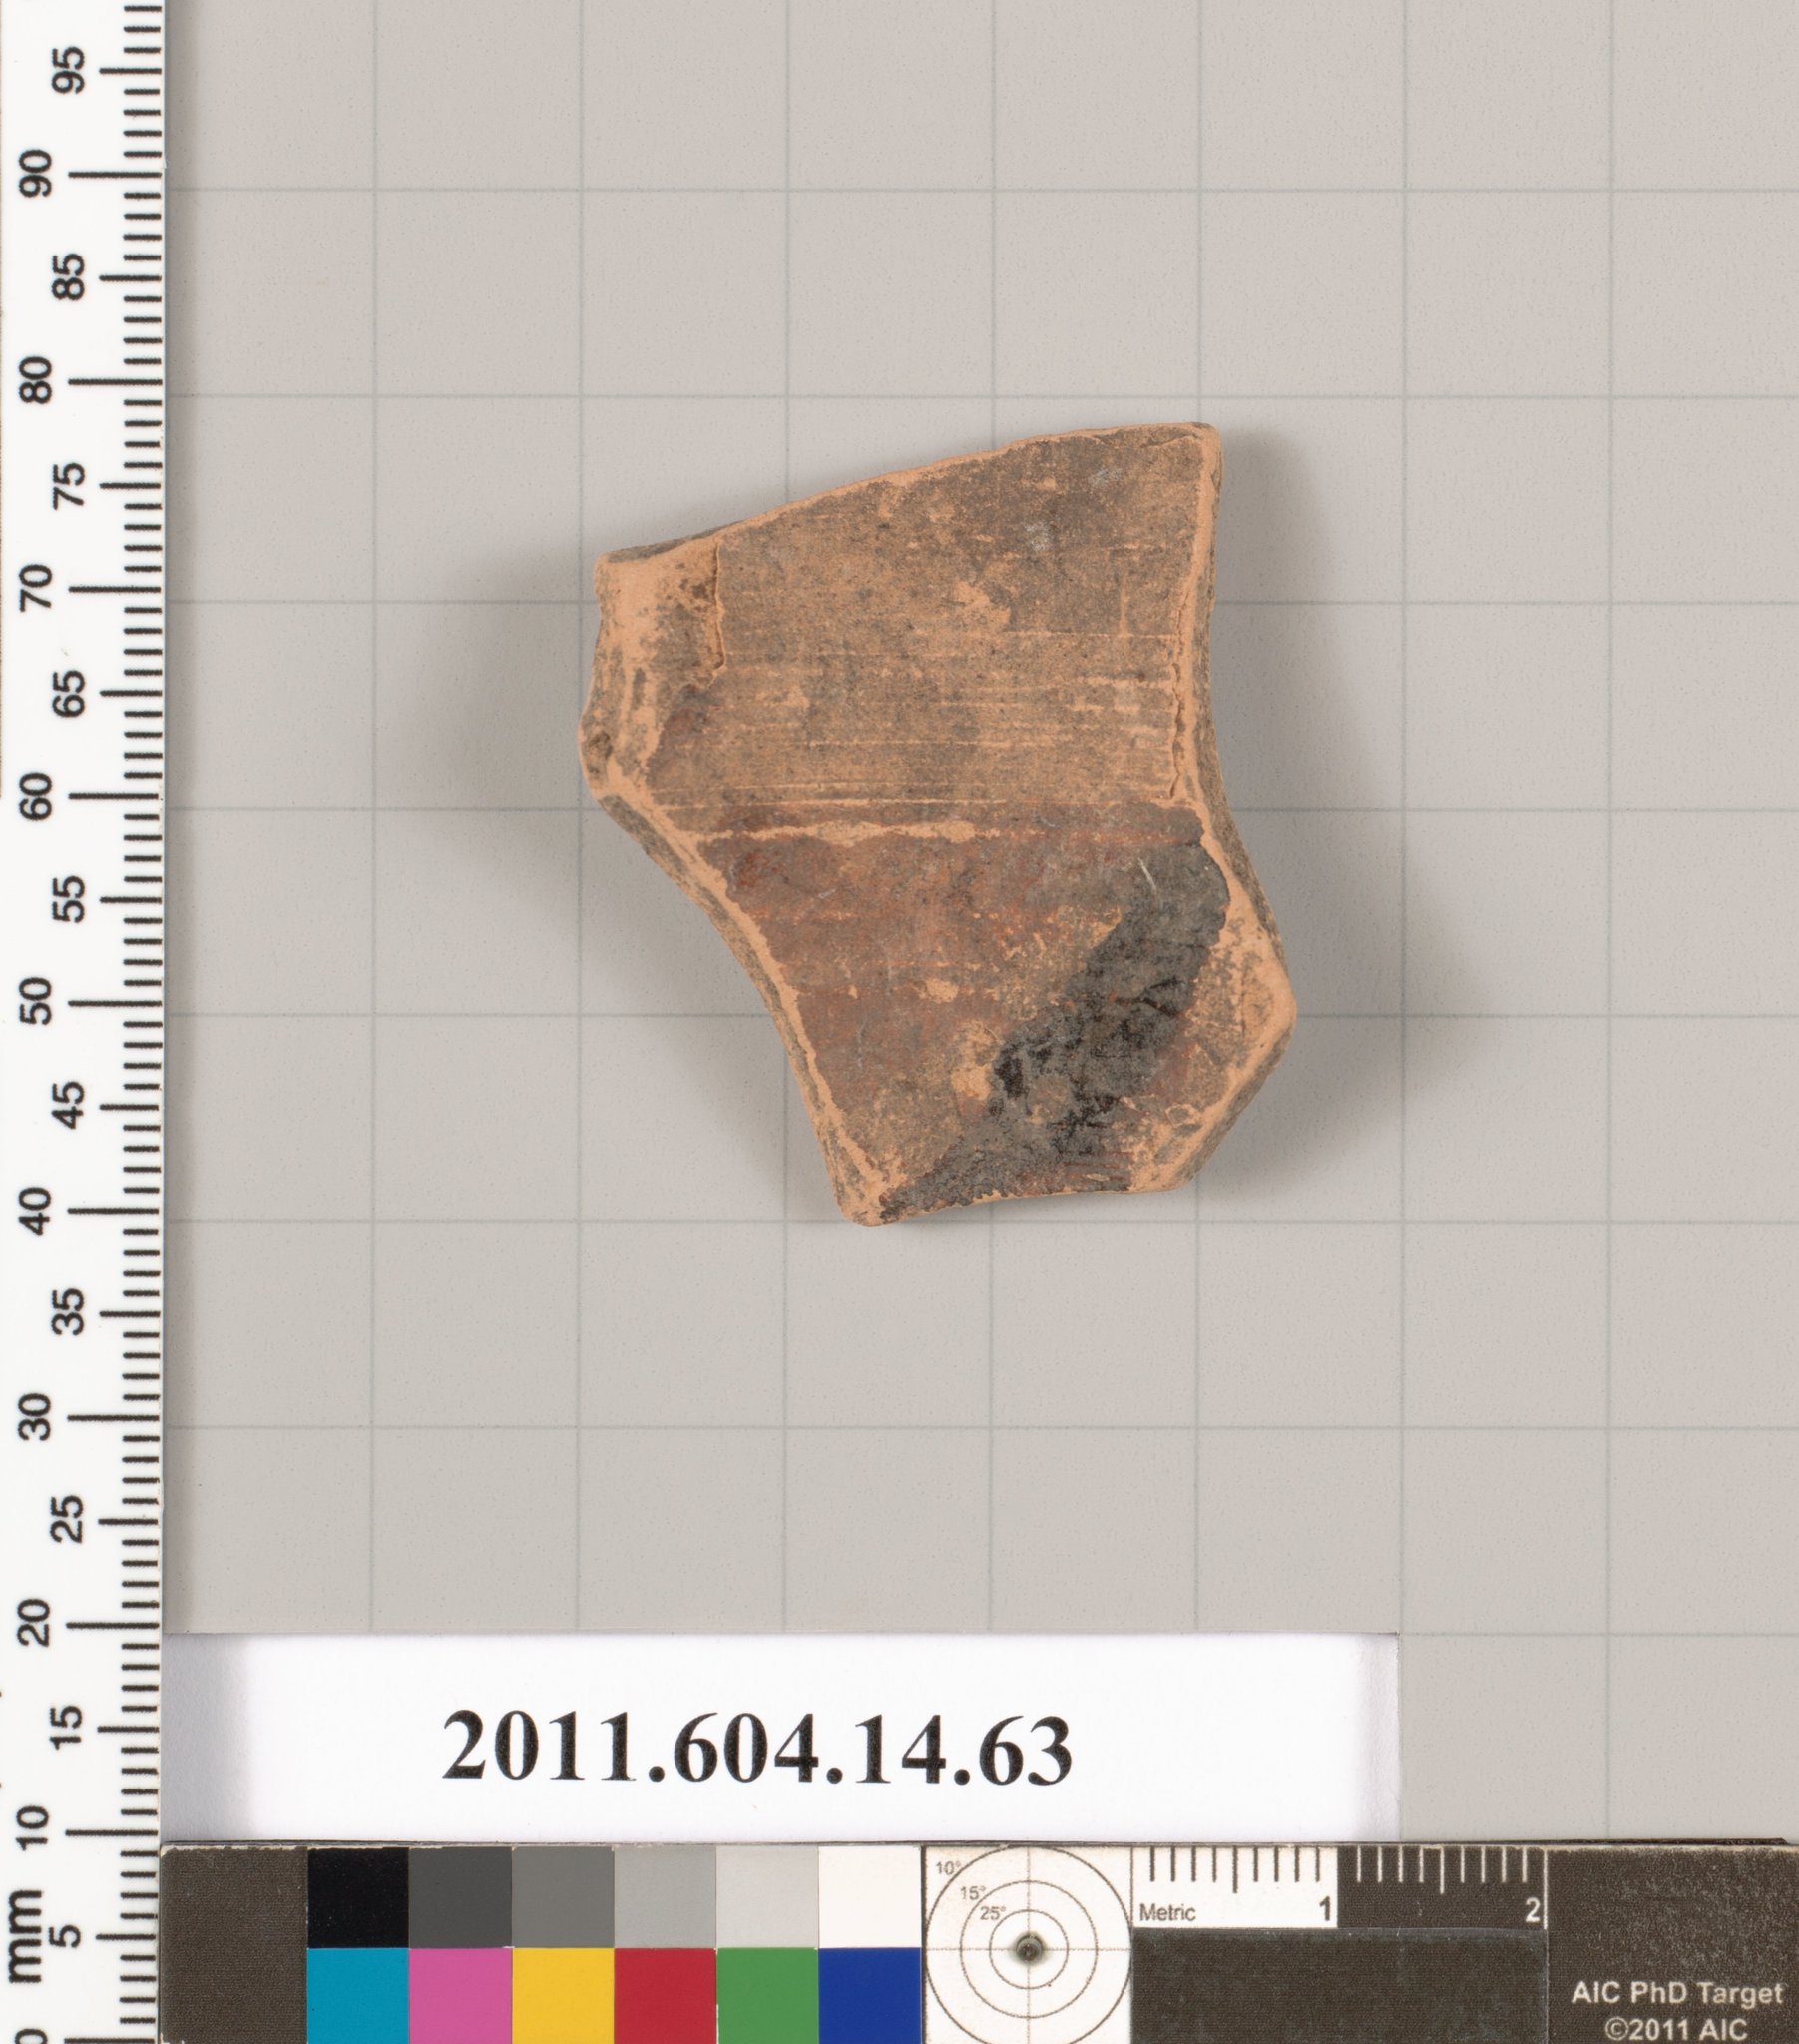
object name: undetermined shape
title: Terracotta fragment of an undetermined shape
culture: unknown fabric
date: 600-301 BCE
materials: terracotta